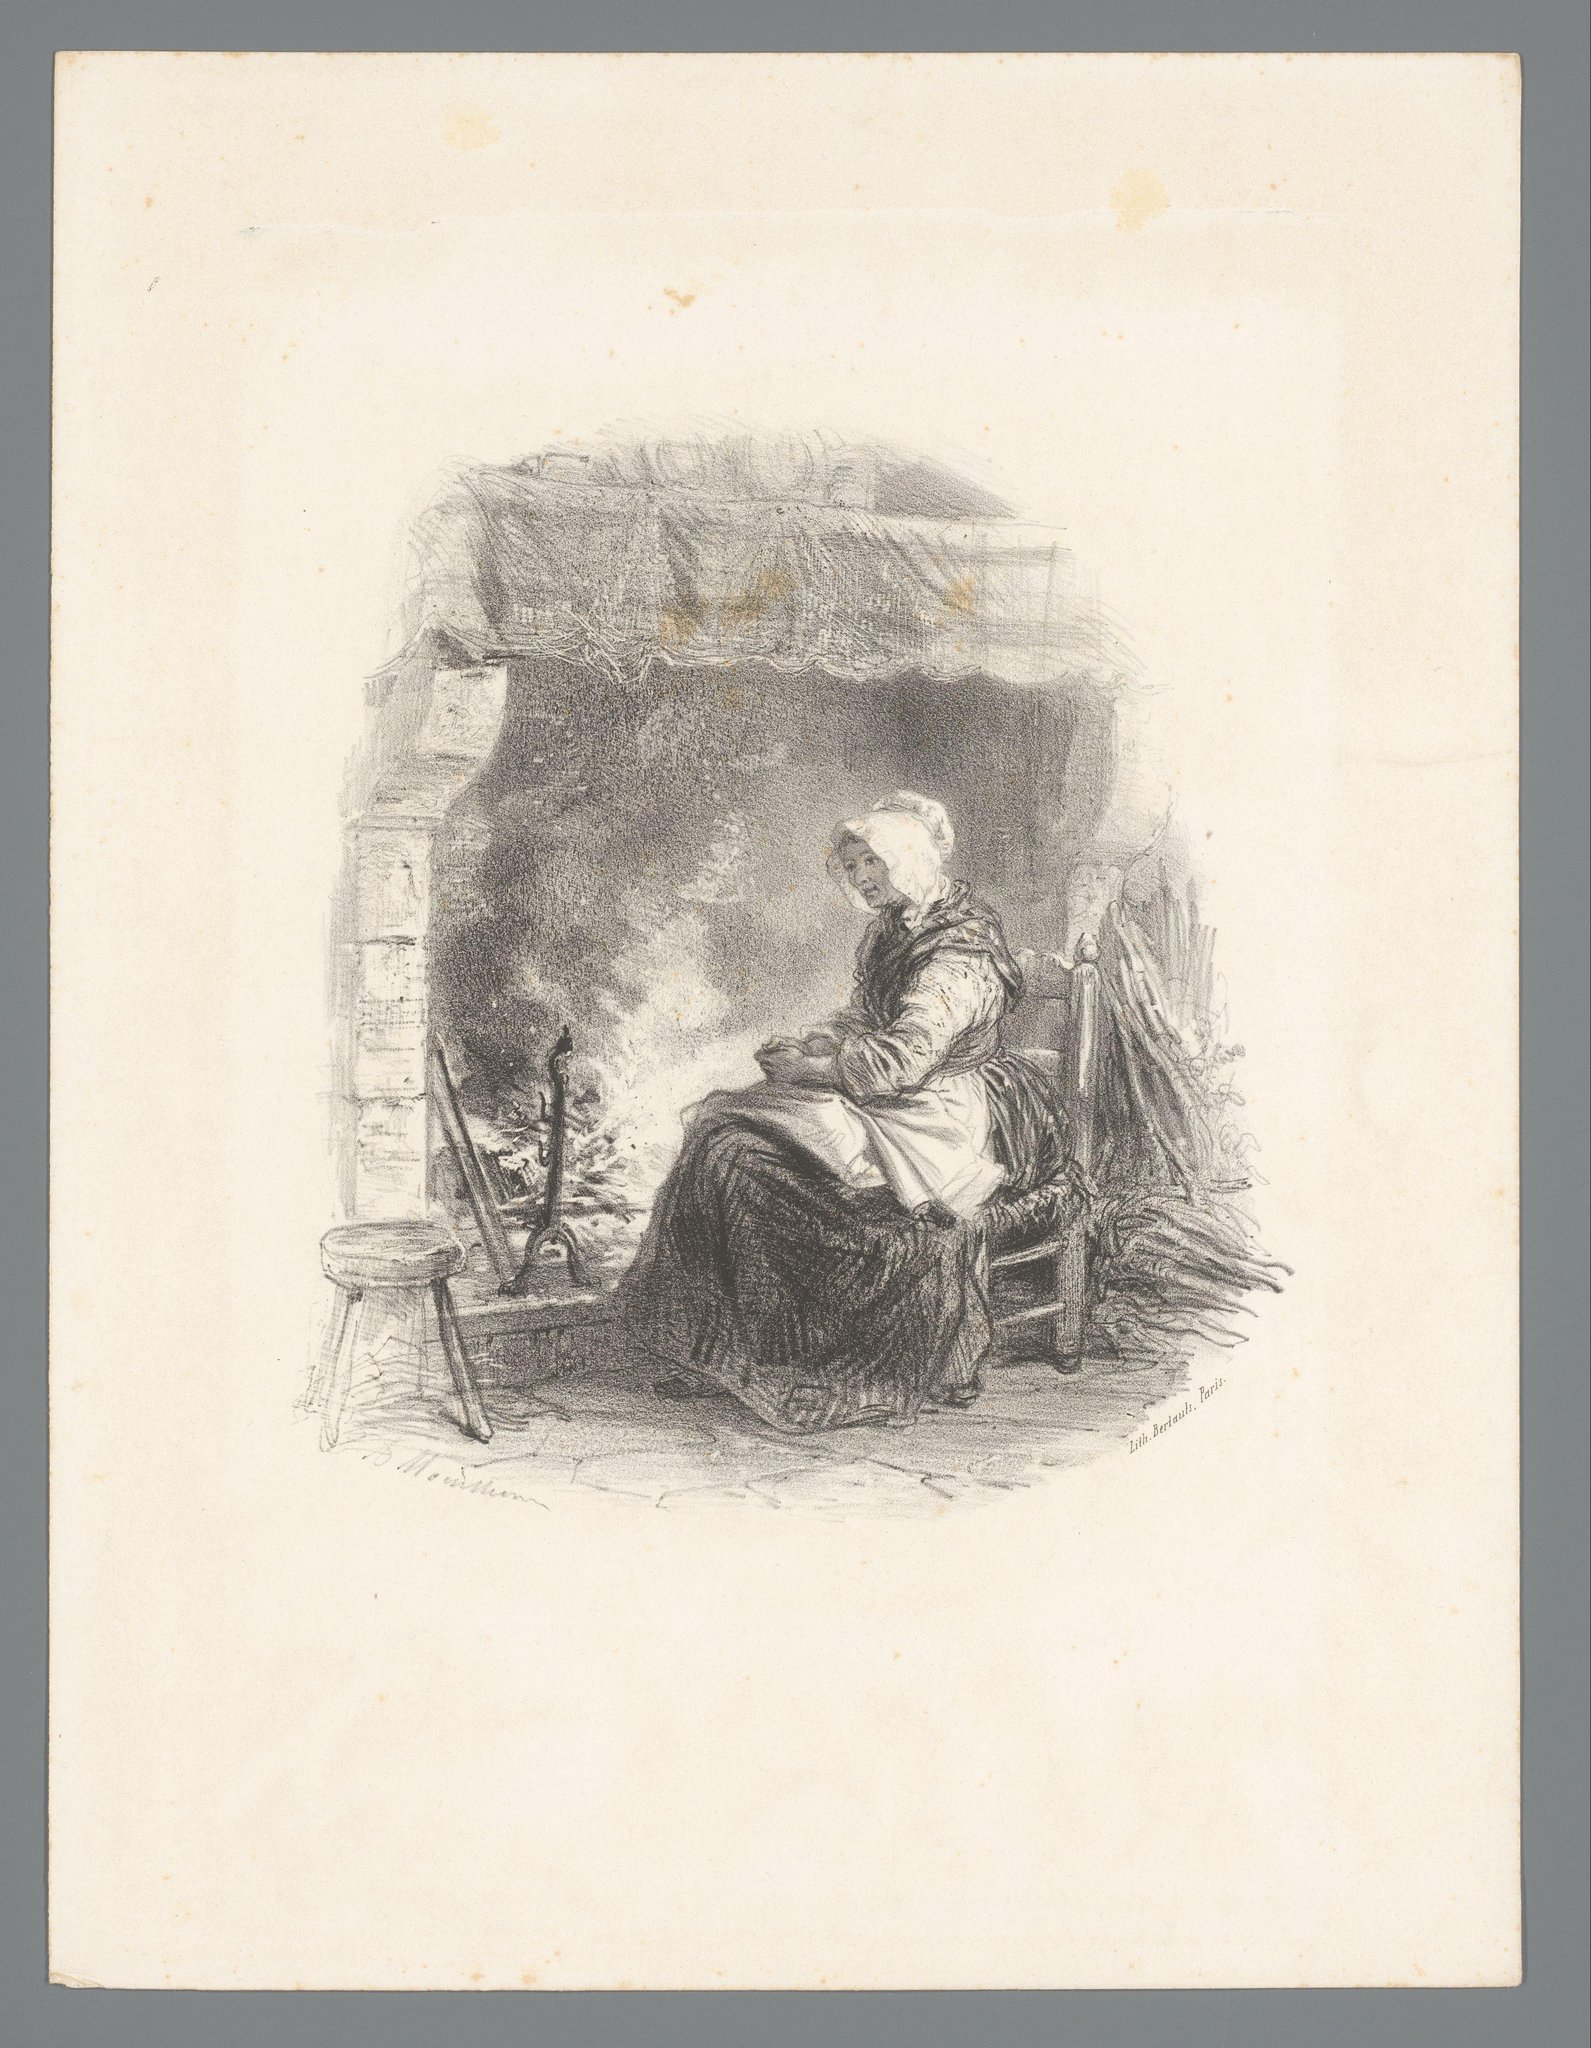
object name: print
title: Oudere vrouw met schort en muts zittend bij het haardvuur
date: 1830-1880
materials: paper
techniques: lithograph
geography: paris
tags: open fire (in general), old woman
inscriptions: collector's mark: Lugt 964